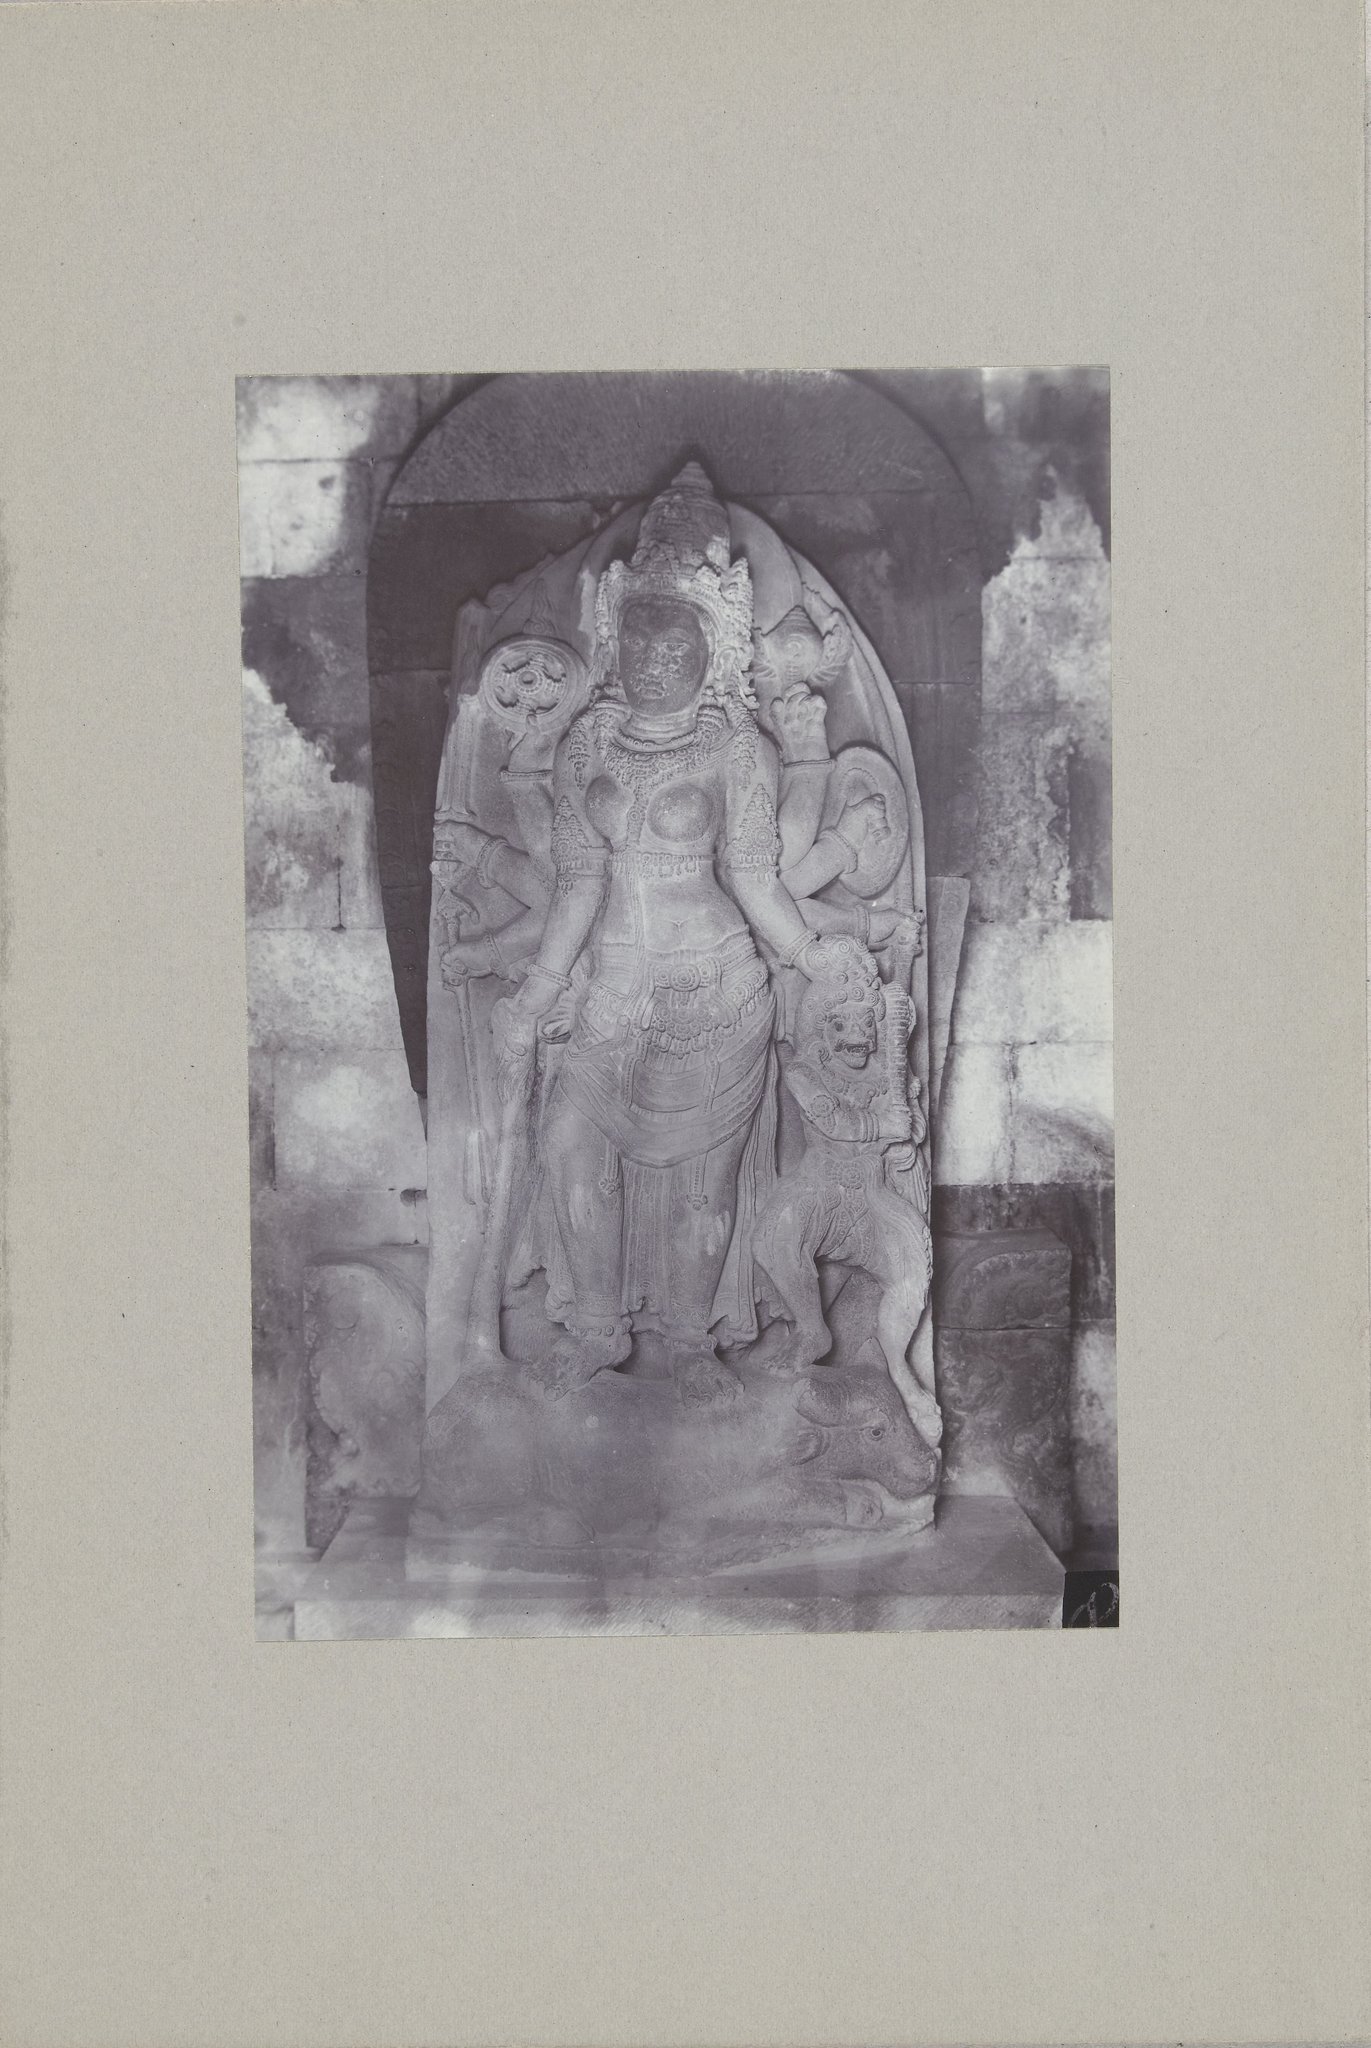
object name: photograph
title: 85a Beeld in zijnis van tempel a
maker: Anonymous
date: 1895-1915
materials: cardboard, paper, photographic support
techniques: gelatin silver print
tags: indonesia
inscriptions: number: ‘8’, annotation: ‘85a Beeld in zijnis van tempel a’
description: Beeld in een zijnis van een tempel van Prambanan bij Jogyakarta, Nederlands-Indië